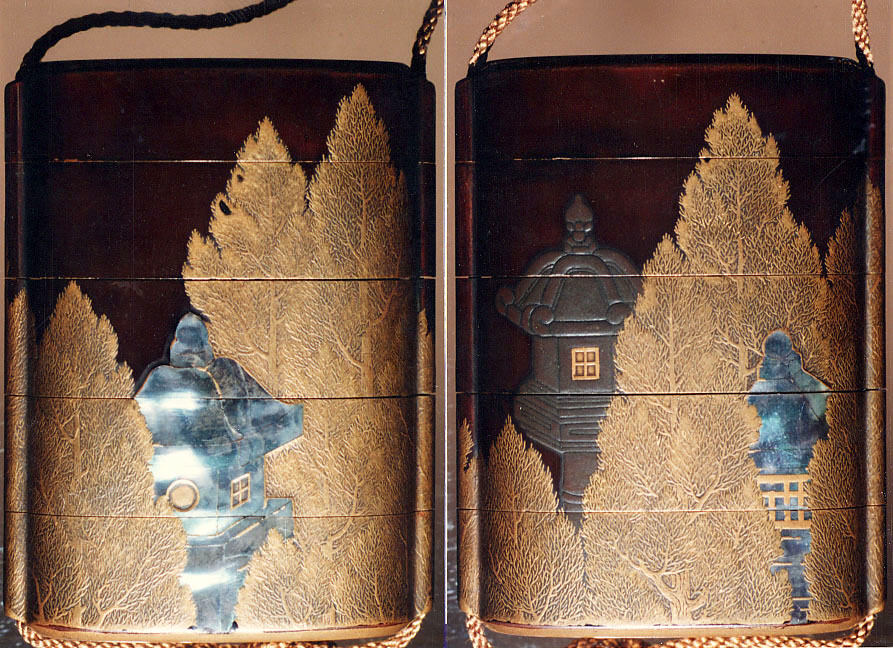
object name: inrō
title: Case (Inrō) with Design of Stone Lanterns beside Cryptomeria Trees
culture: japanese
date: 1701-1900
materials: gold, lacquer, silver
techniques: fundame, hiramakie, roiro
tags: trees,lanterns